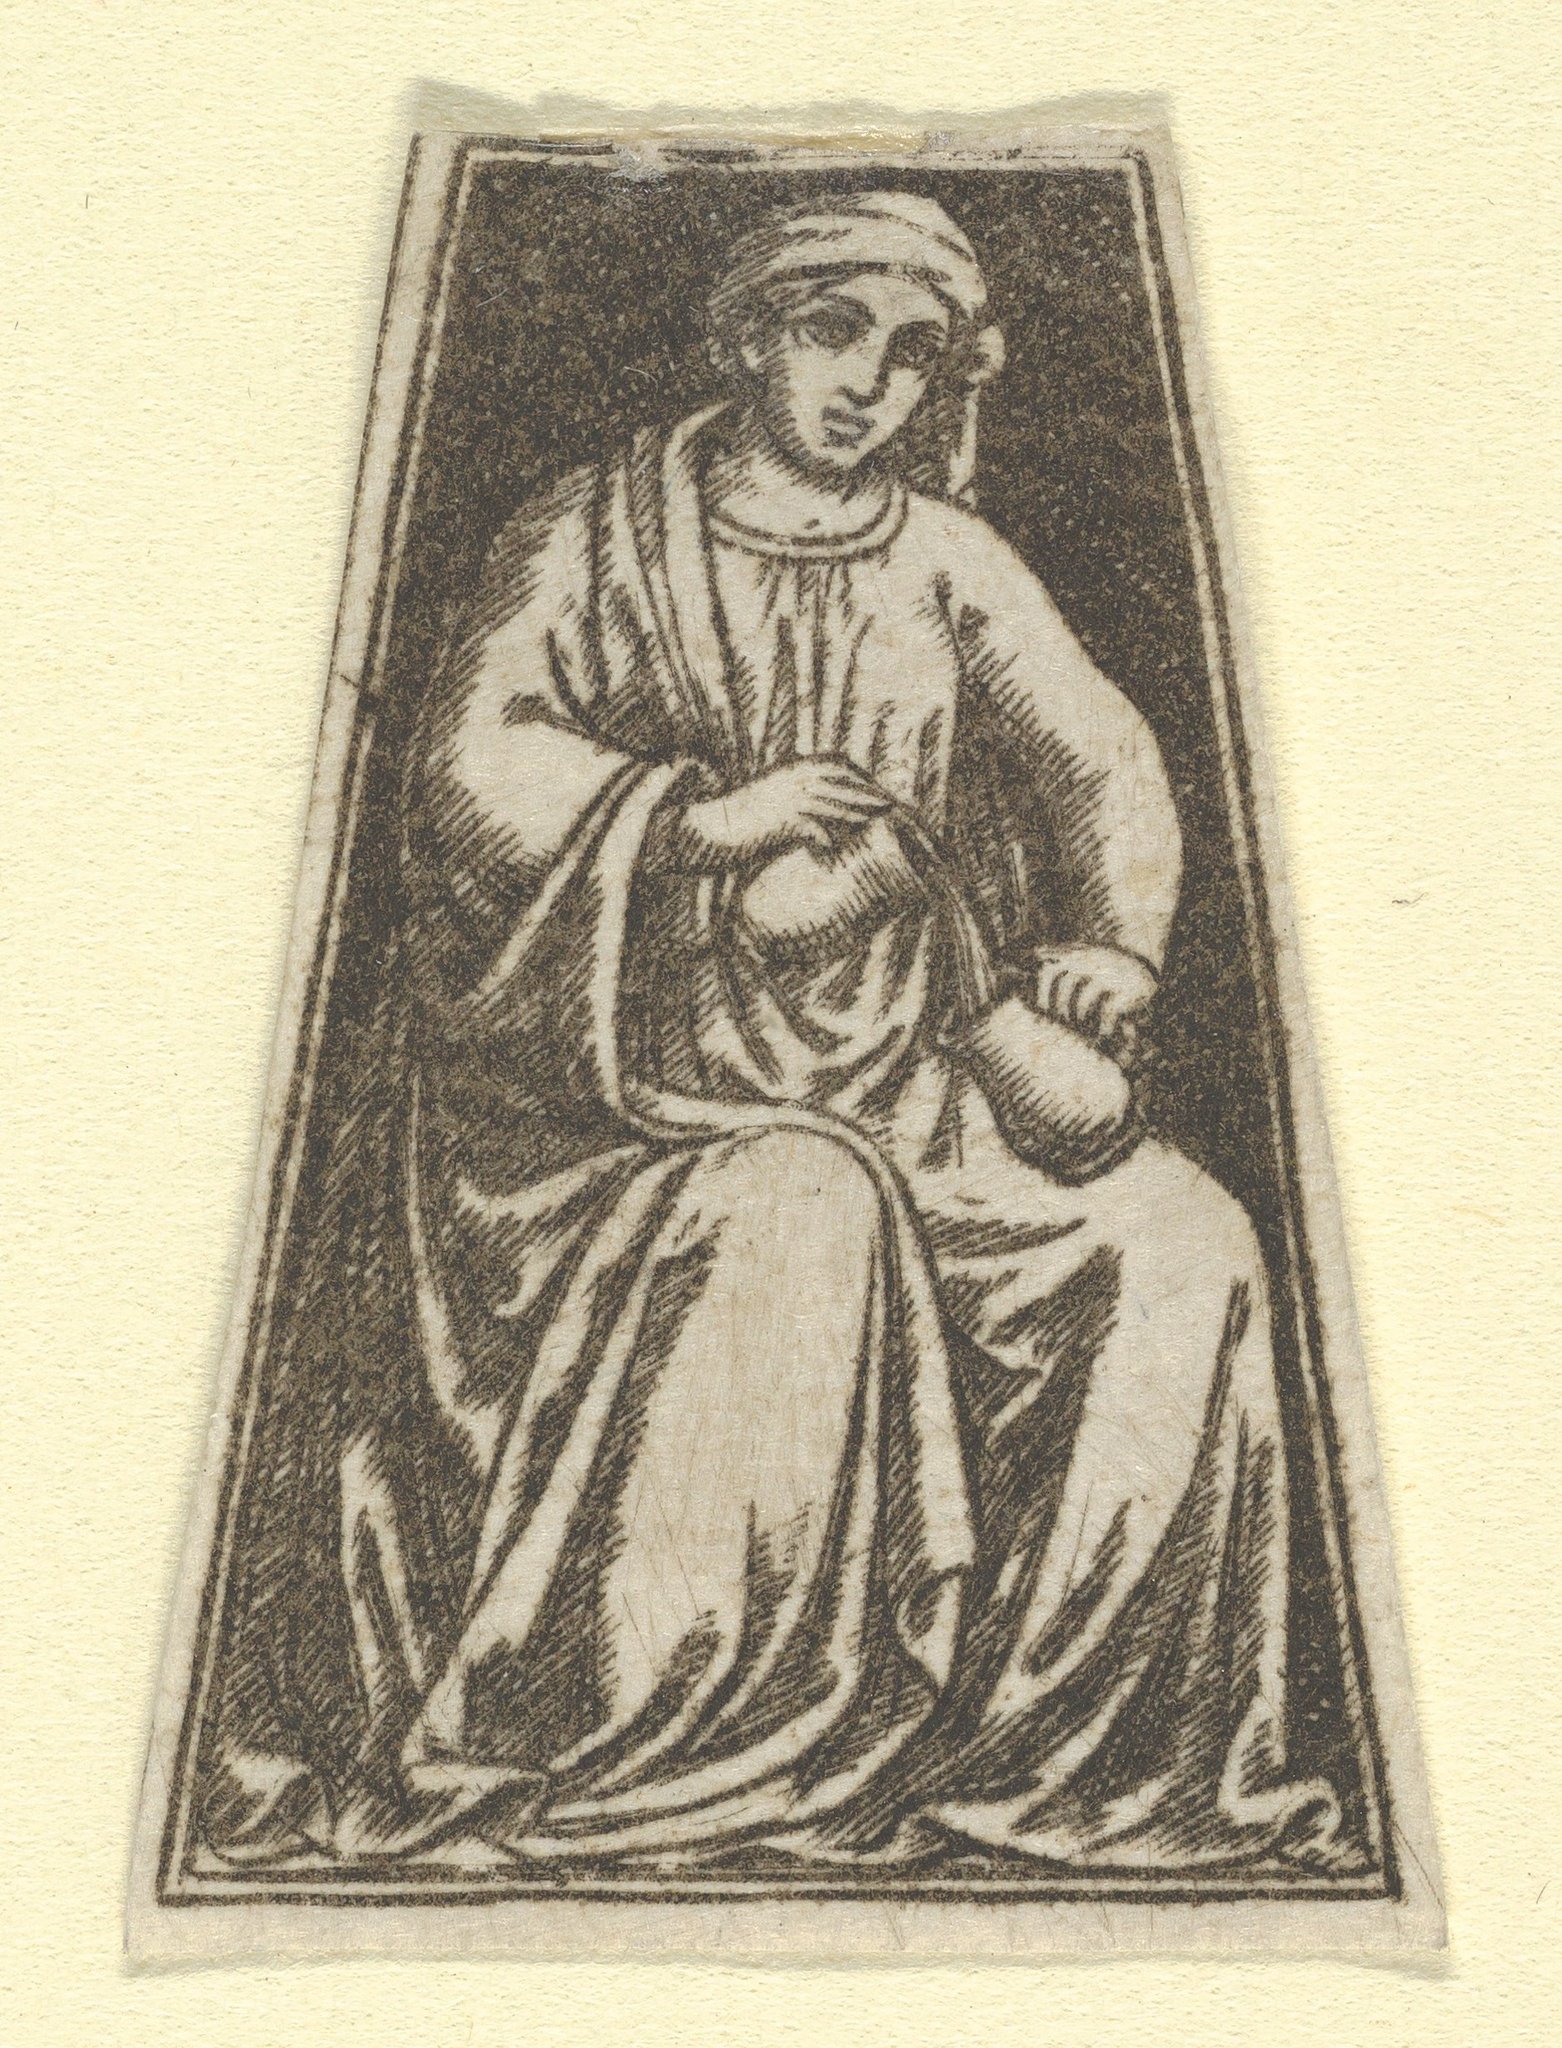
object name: print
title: The cardinal virtue of Temperance represented by a seated woman pouring wine(?) from one jug into another (possibly a modern impression)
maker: Anonymous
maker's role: artist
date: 1480-1520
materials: niello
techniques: engraving, printing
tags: women